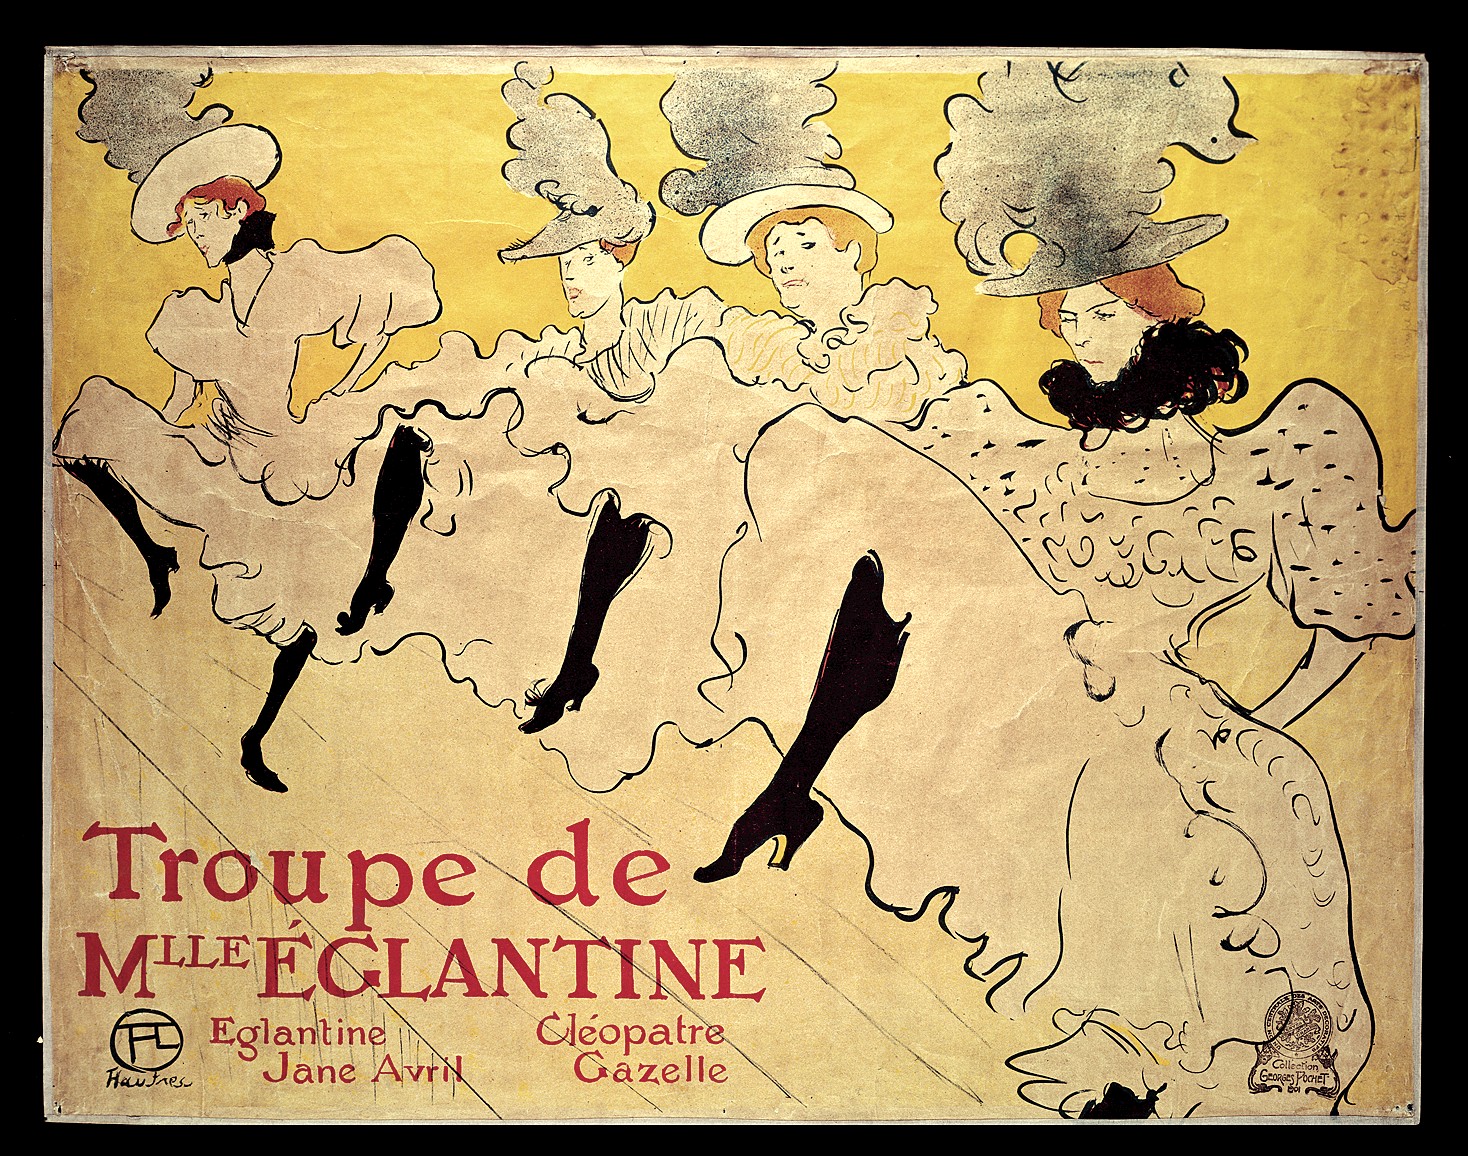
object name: print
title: La Troupe de Mademoiselle Eglantine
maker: henri de toulouse-lautrec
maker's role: artist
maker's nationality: french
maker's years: 1864-1901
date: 1895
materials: paper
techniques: lithograph, printing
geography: france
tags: women,dancing